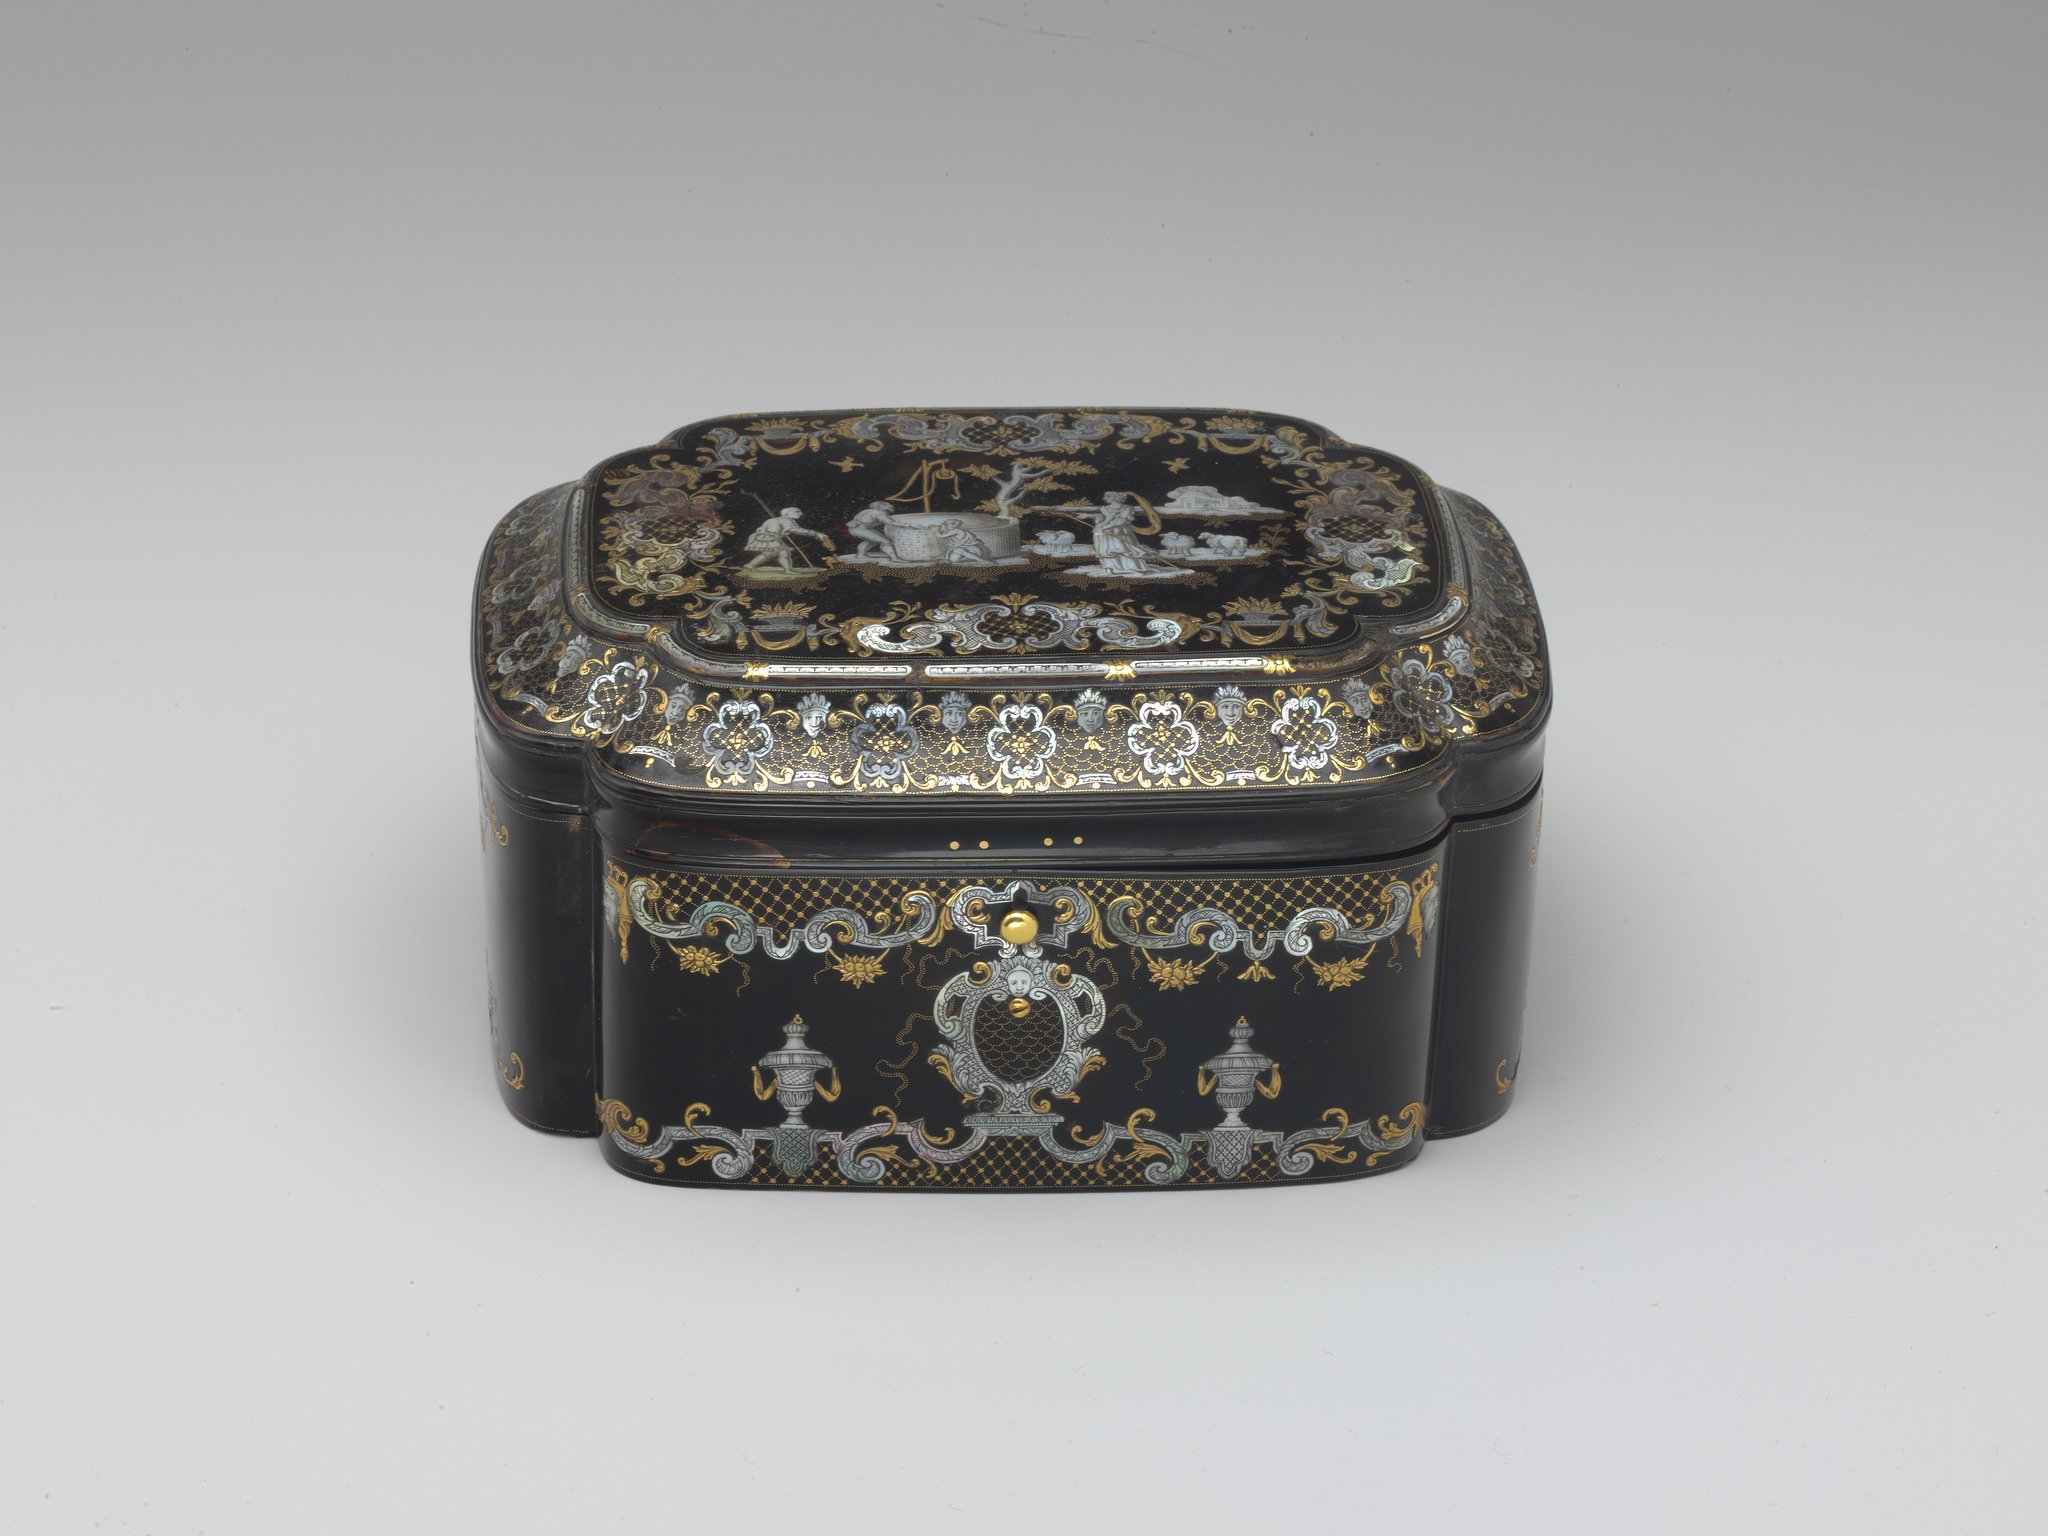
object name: box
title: Box with Rachel Meeting Jacob at the Well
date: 1730-1750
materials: gold, mother of pearl, shell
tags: human figures,wells